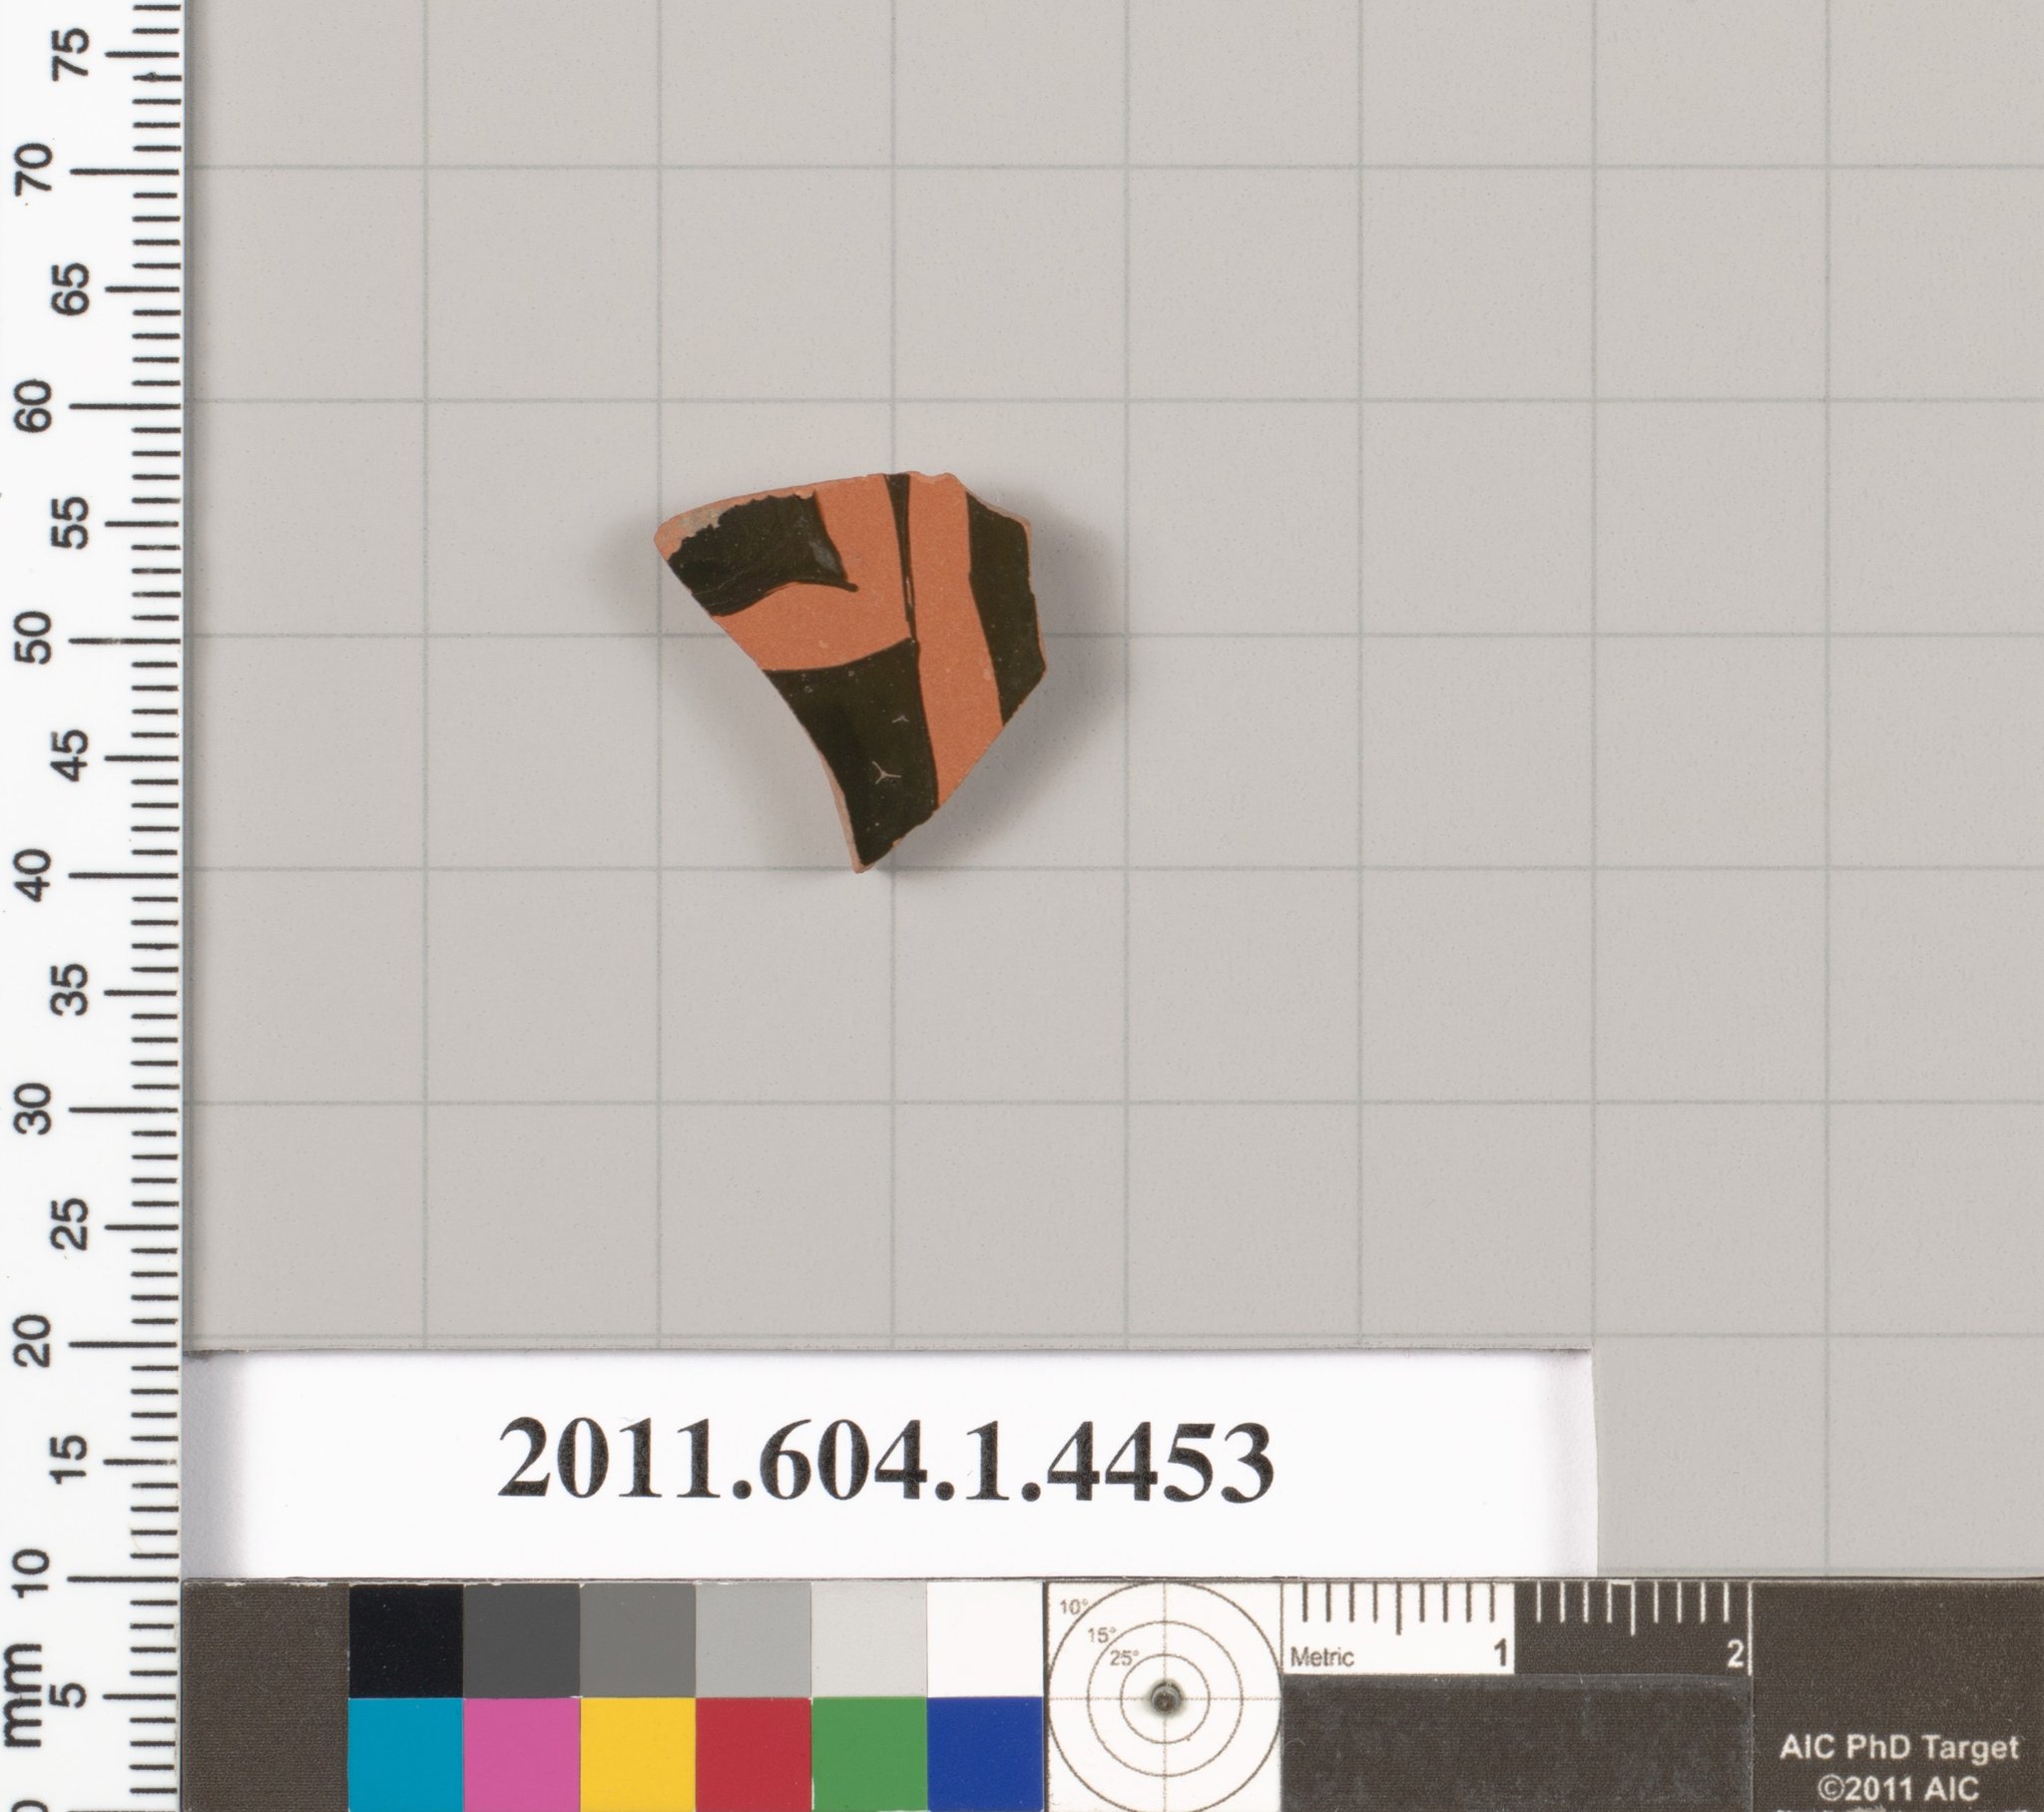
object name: kylix fragment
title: Terracotta fragment of a kylix (drinking cup)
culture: greek, attic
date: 490-470 BCE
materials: terracotta